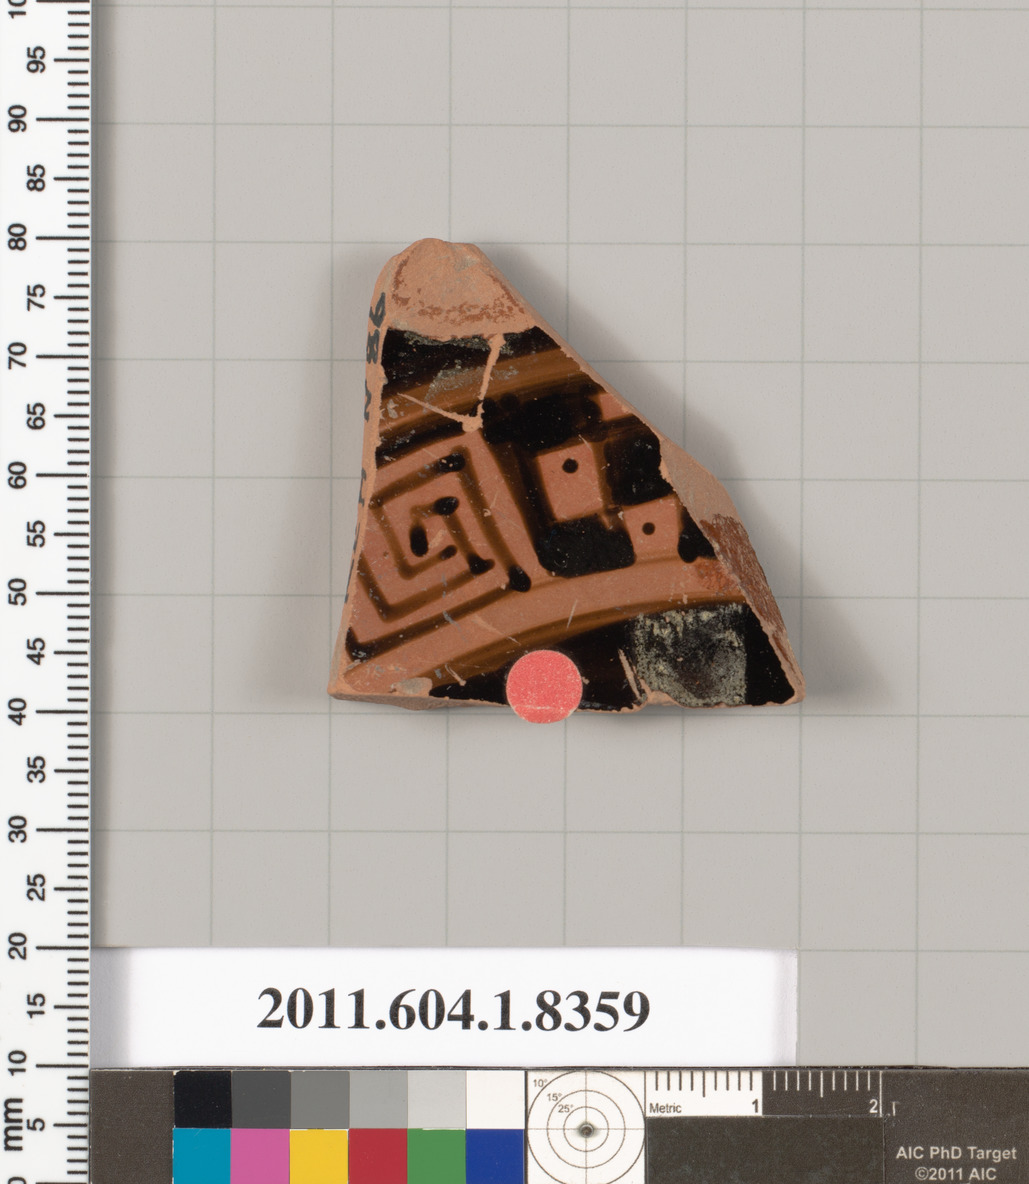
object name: kylix fragment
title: Terracotta fragment of a kylix (drinking cup)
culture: greek, attic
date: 400-351 BCE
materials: terracotta